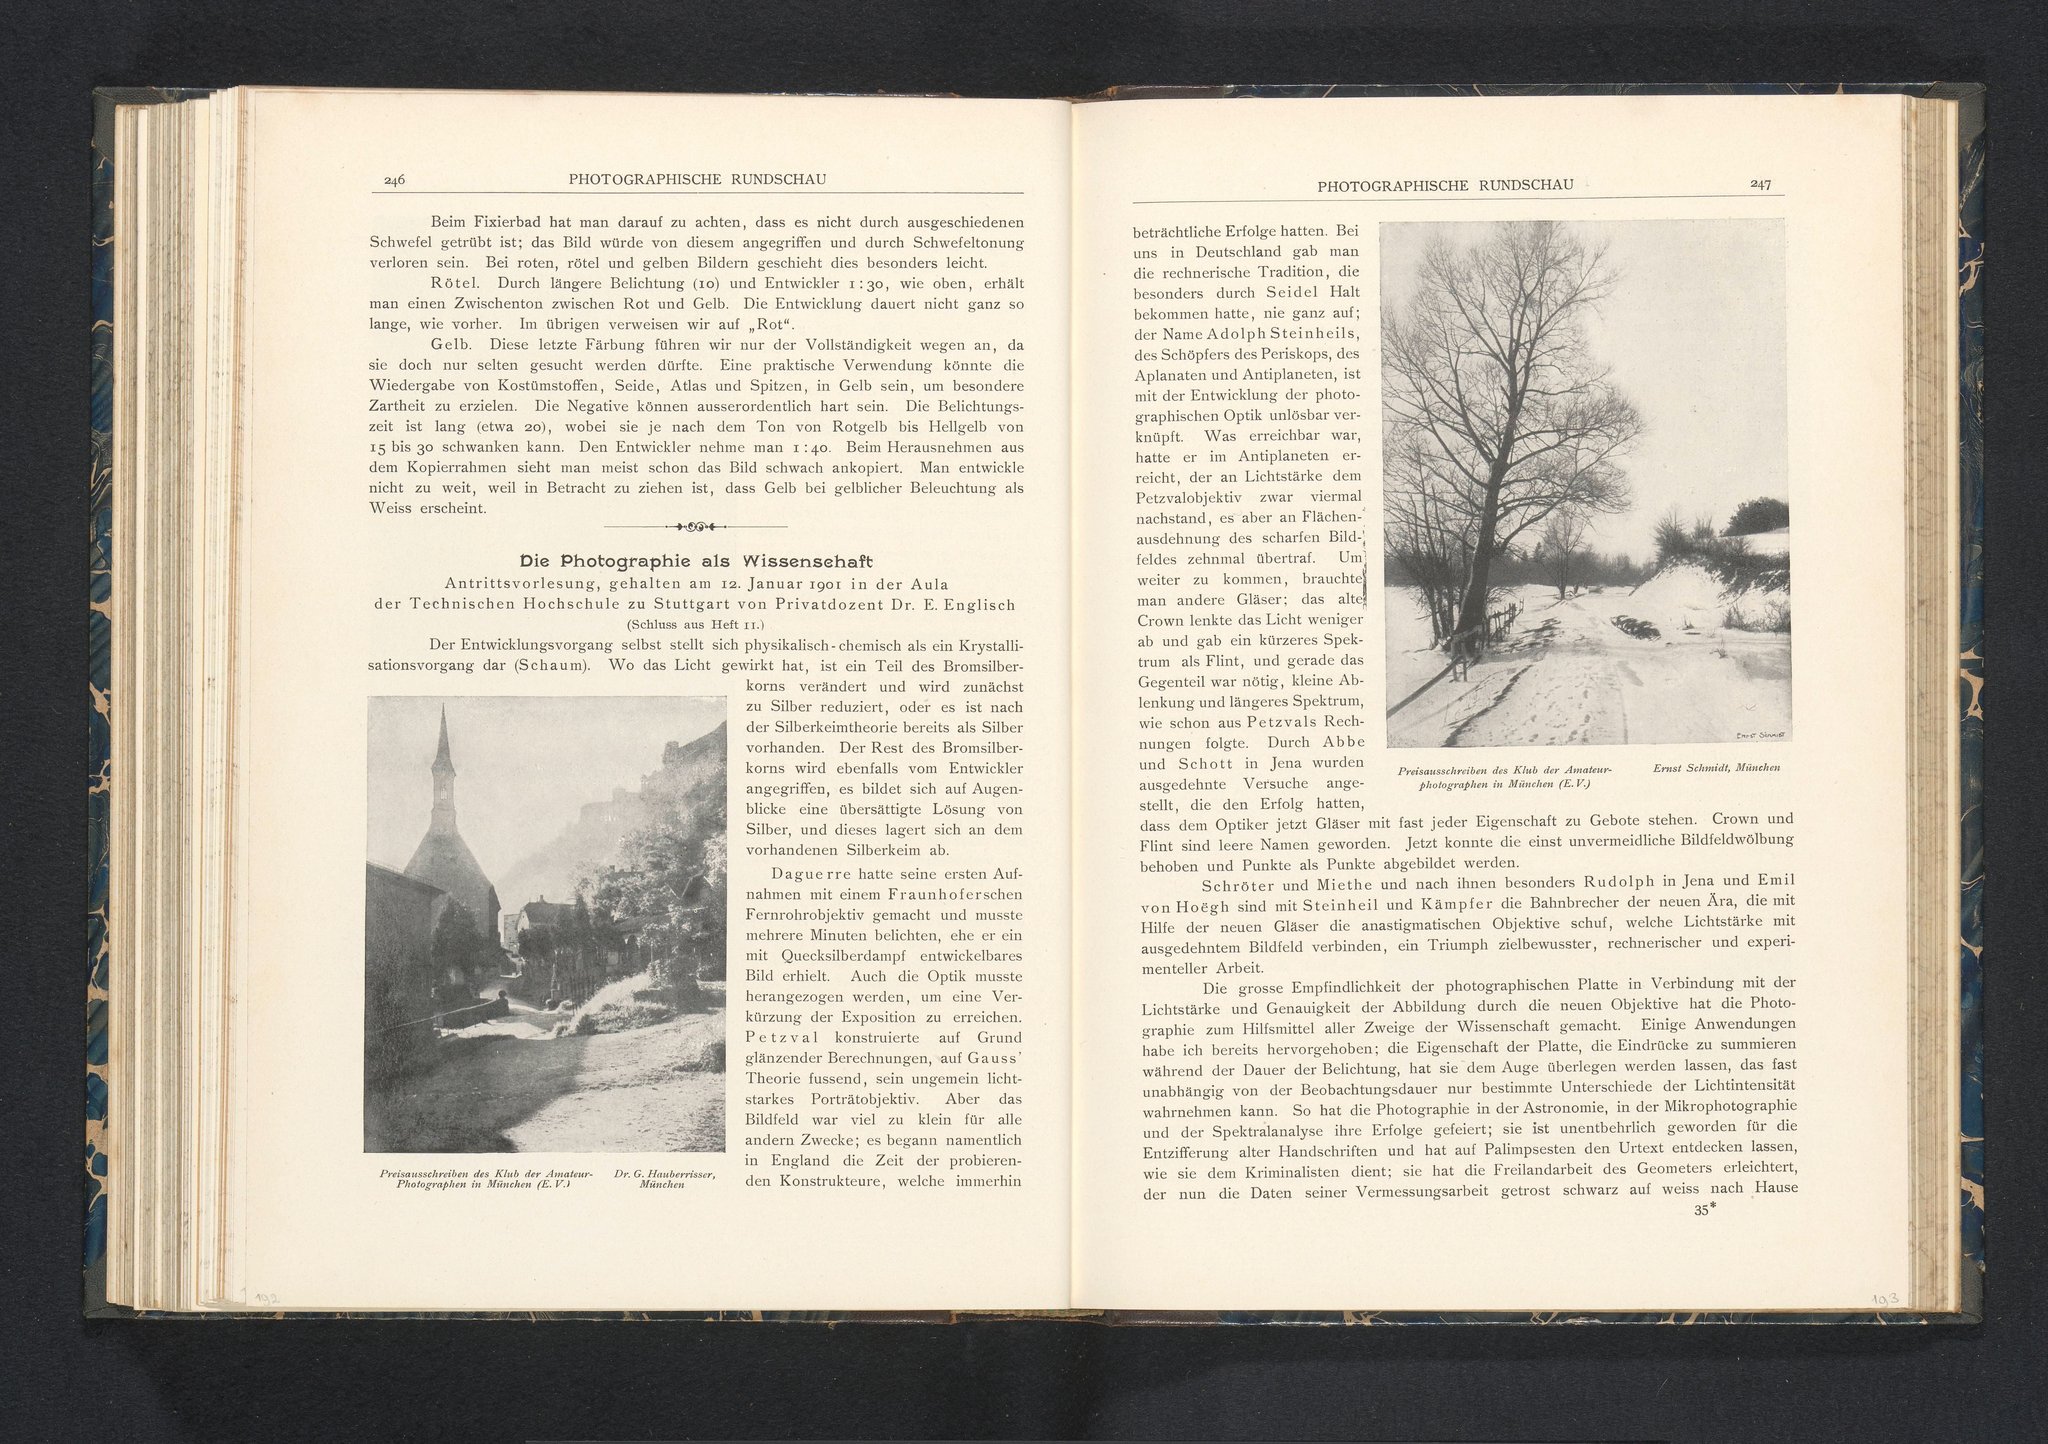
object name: page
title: Winters landschap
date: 1896-1901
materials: paper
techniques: autotype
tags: landscapes, snow